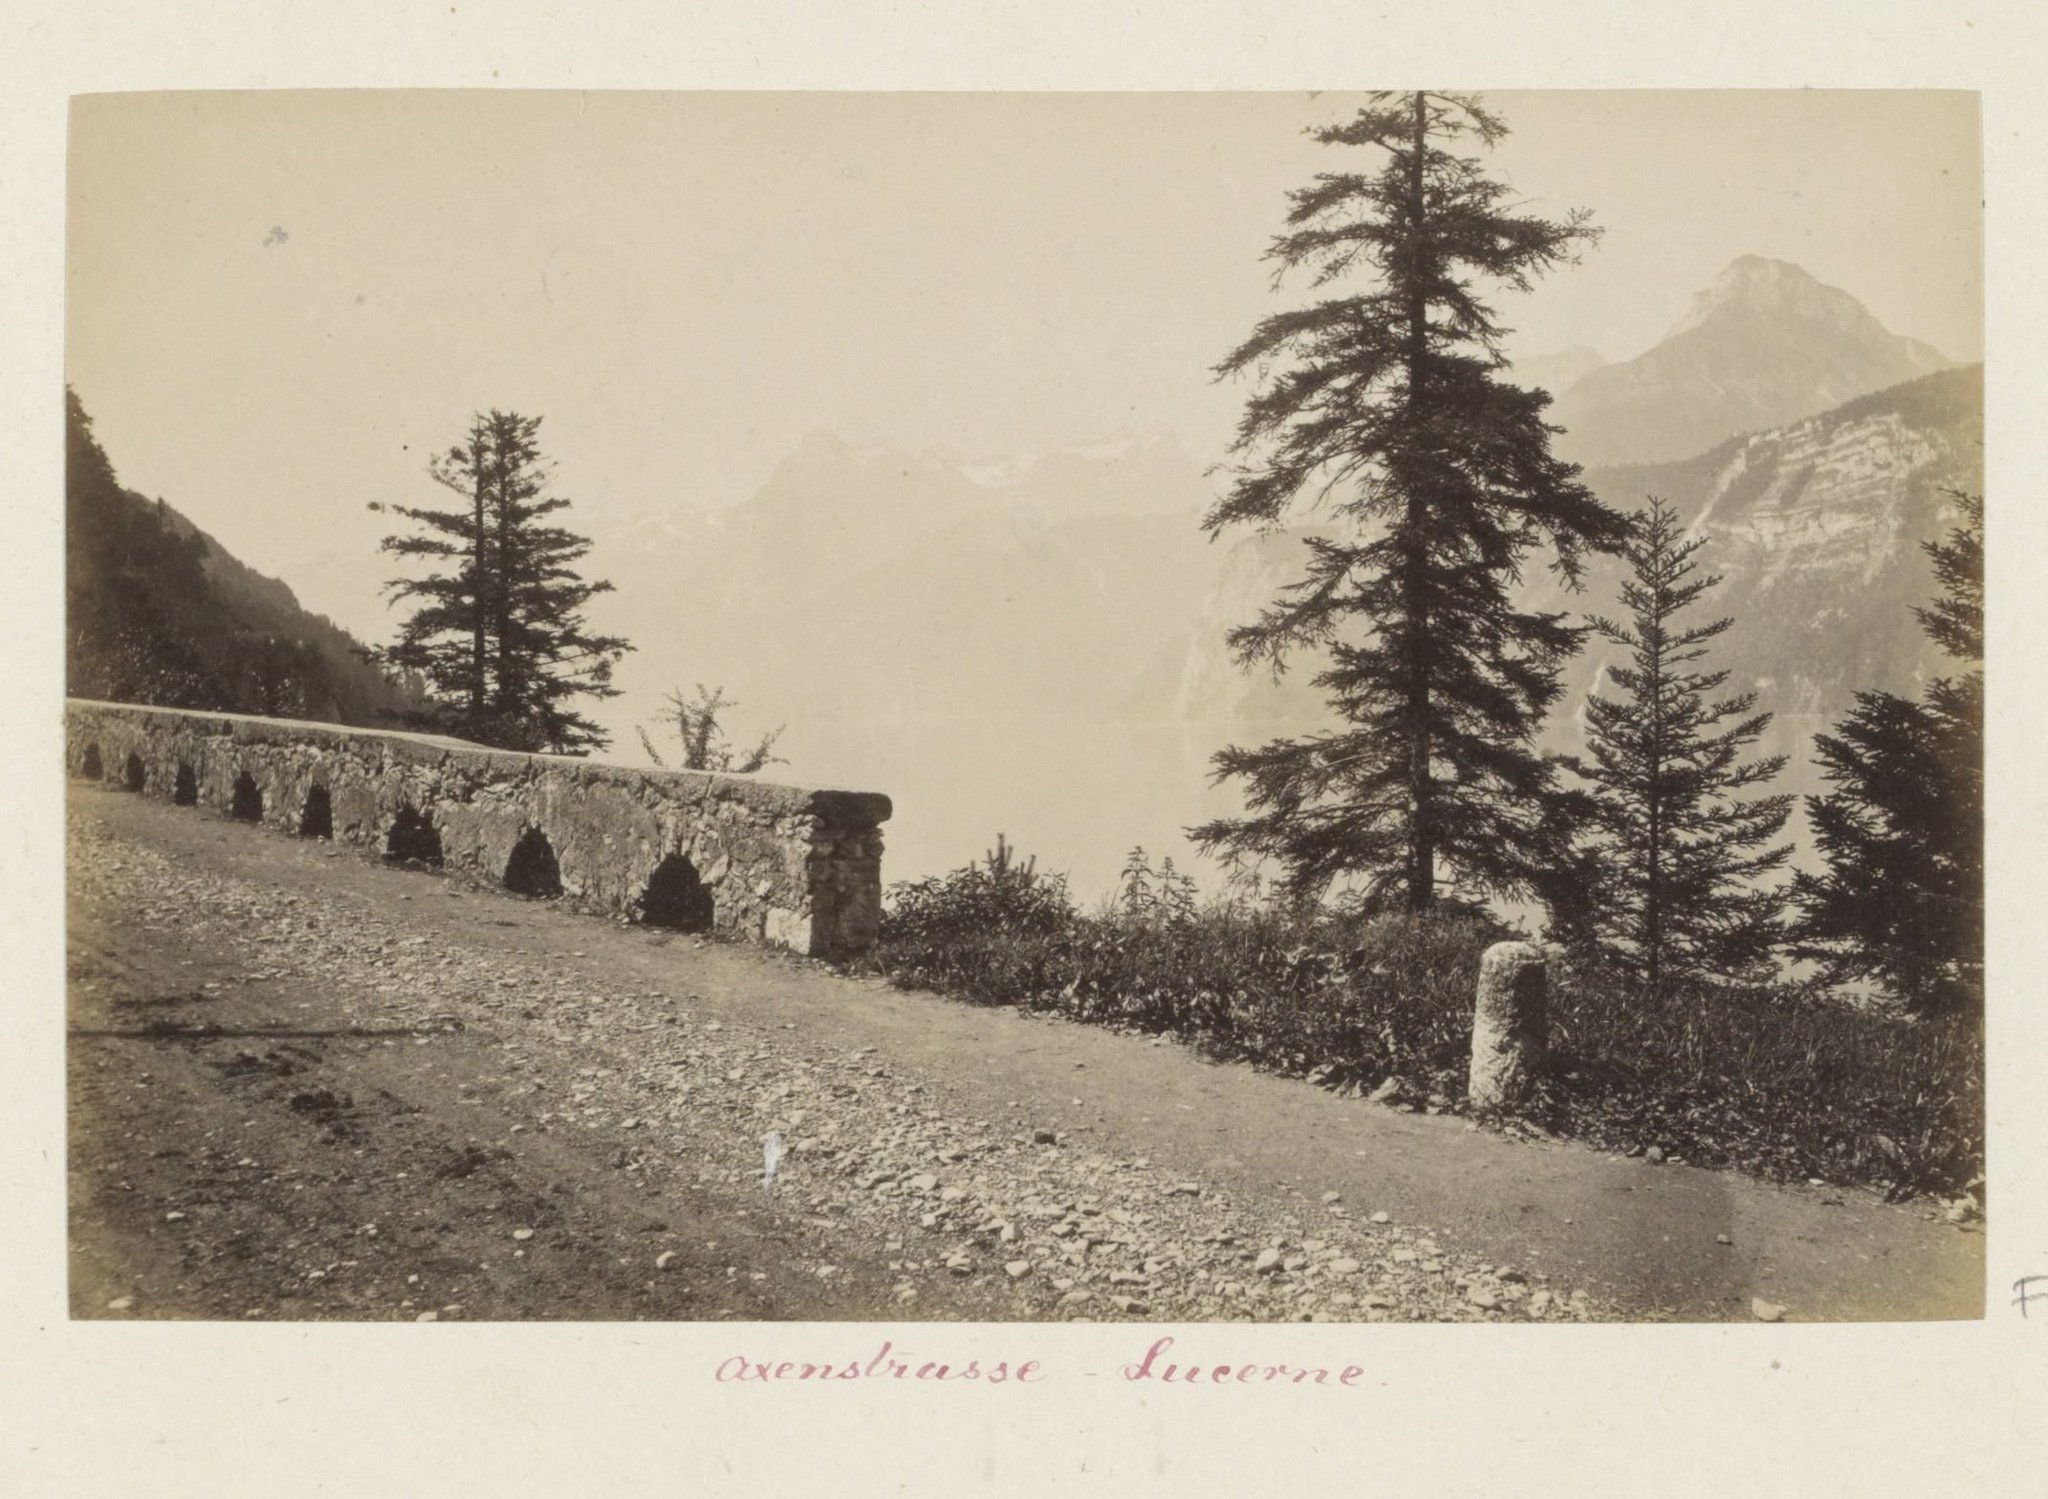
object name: photograph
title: Axenstrasse met een brug in de bergen bij Luzern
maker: Anonymous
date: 1860-1890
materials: paper, photographic support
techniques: albumen print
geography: lucerne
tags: public road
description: Onderdeel van Reisalbum met foto's van Zwitserland, Oostenrijk, Italië en Duitsland.